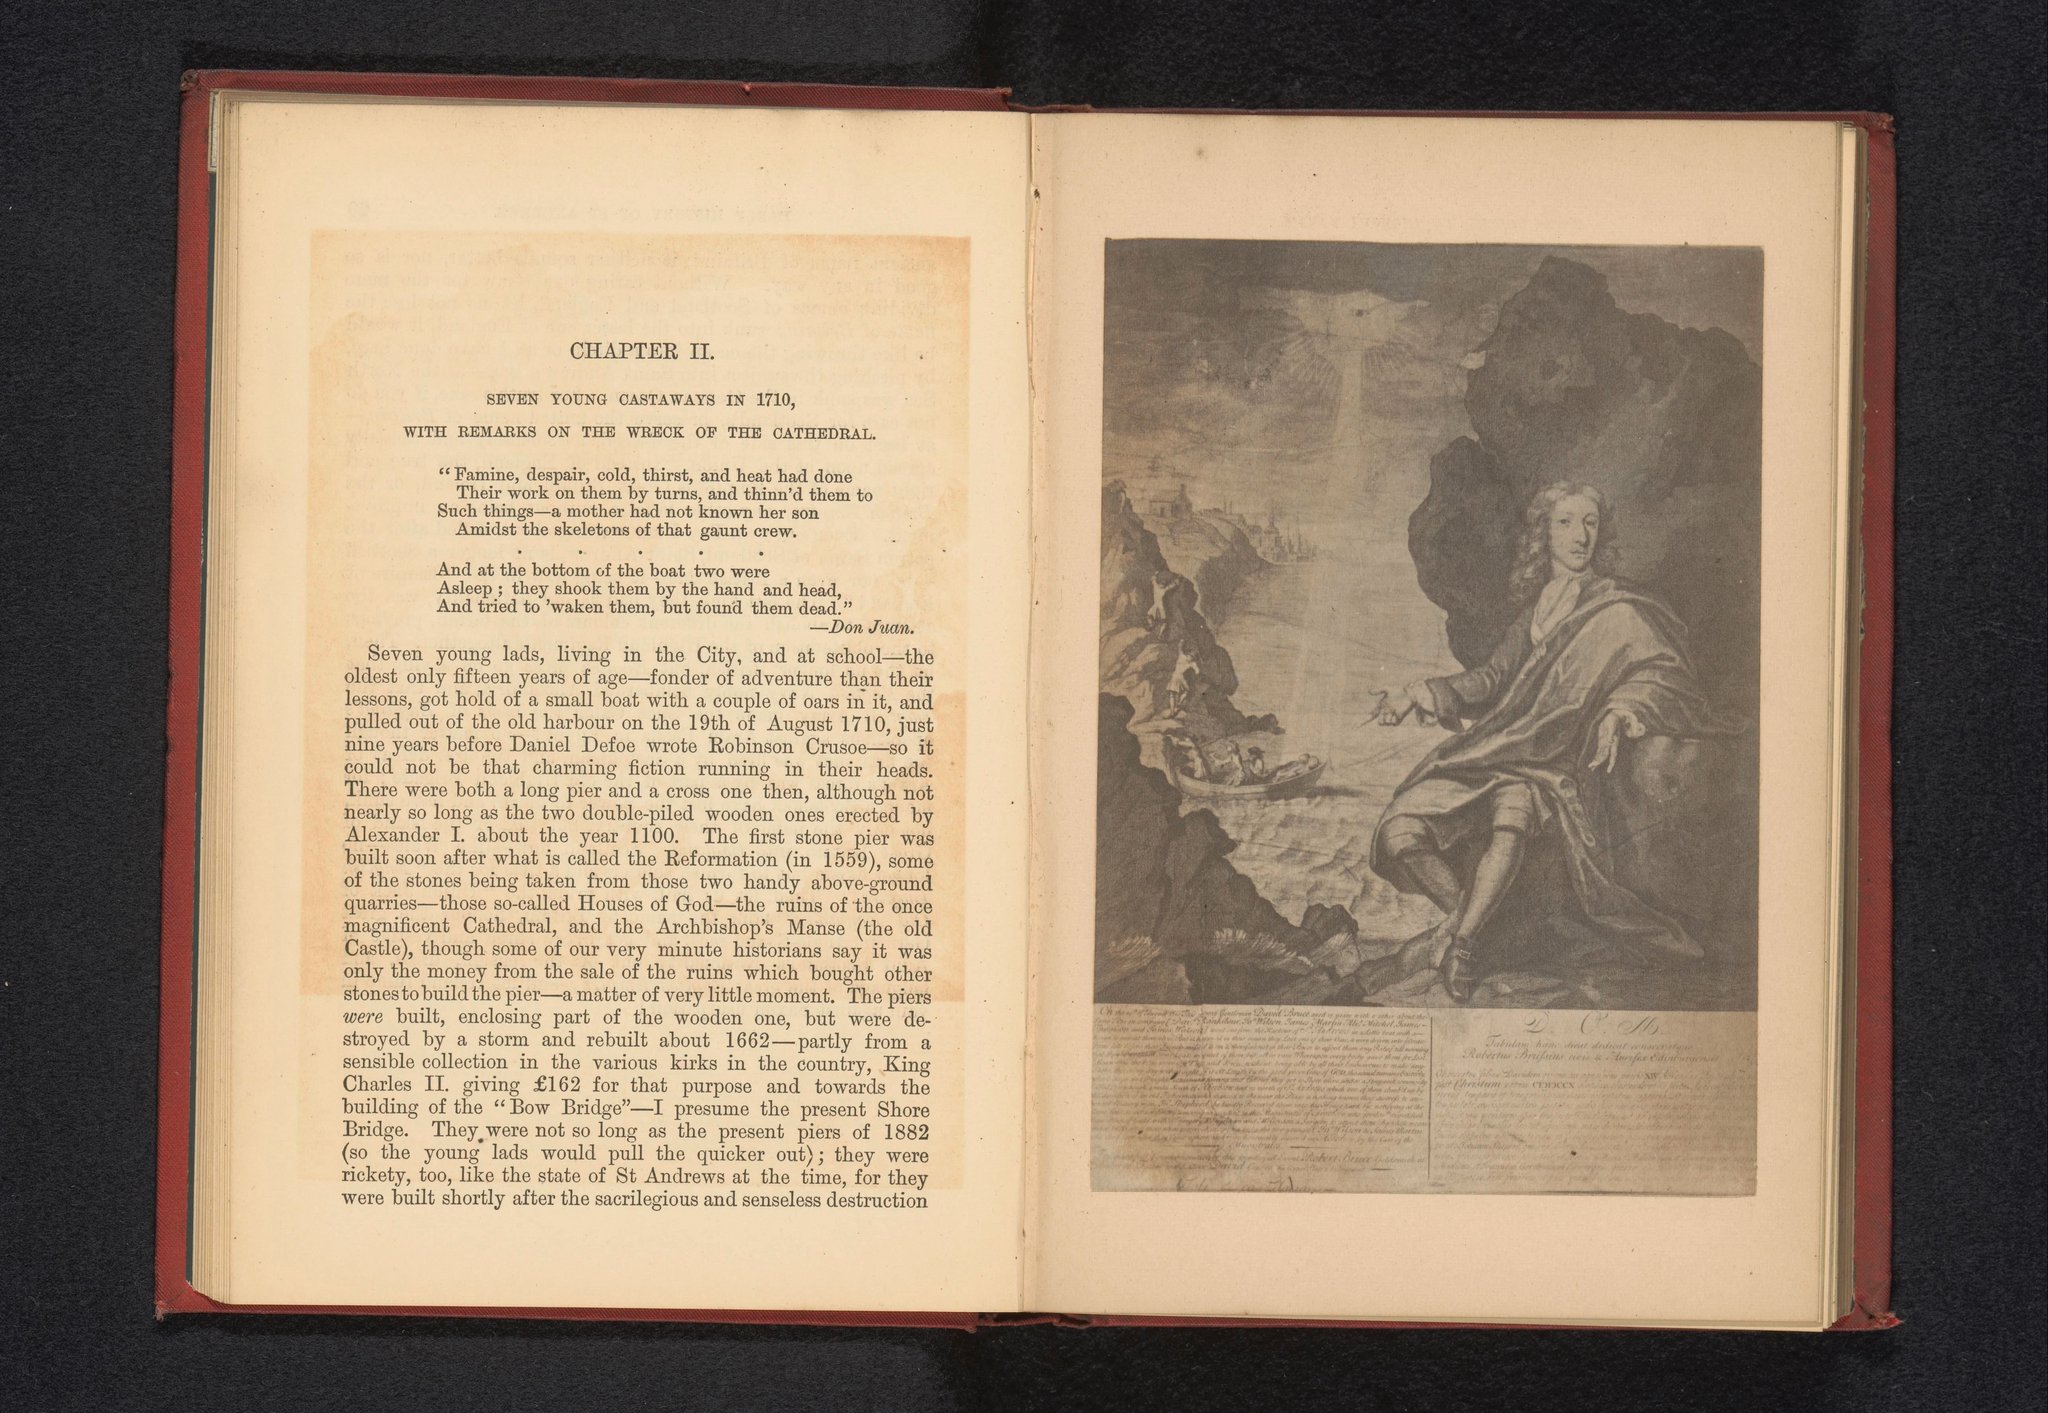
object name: photograph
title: Fotoreproductie van een ontwerp van de Seven Castaways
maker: john dryburgh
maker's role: fotograaf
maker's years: 1846-1887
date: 1879-1884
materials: photographic support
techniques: platinum process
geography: saint andrews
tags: drowning, shipwrecked person